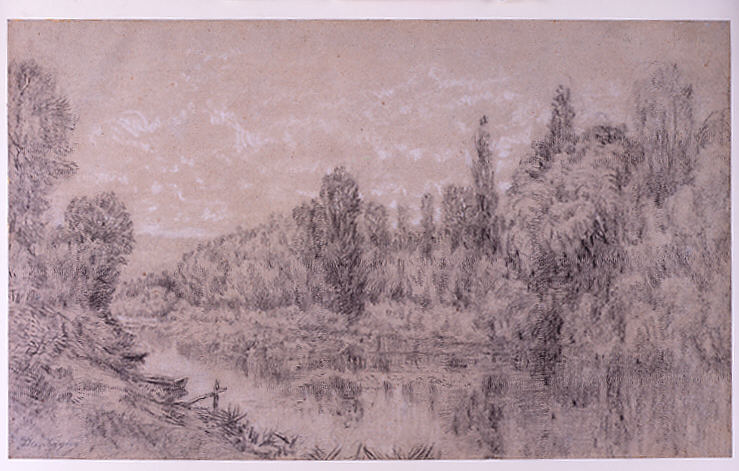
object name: drawing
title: Landscape along a River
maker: charles-françois daubigny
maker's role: artist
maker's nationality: french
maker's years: 1817-1878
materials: chalk, paper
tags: rivers,landscapes